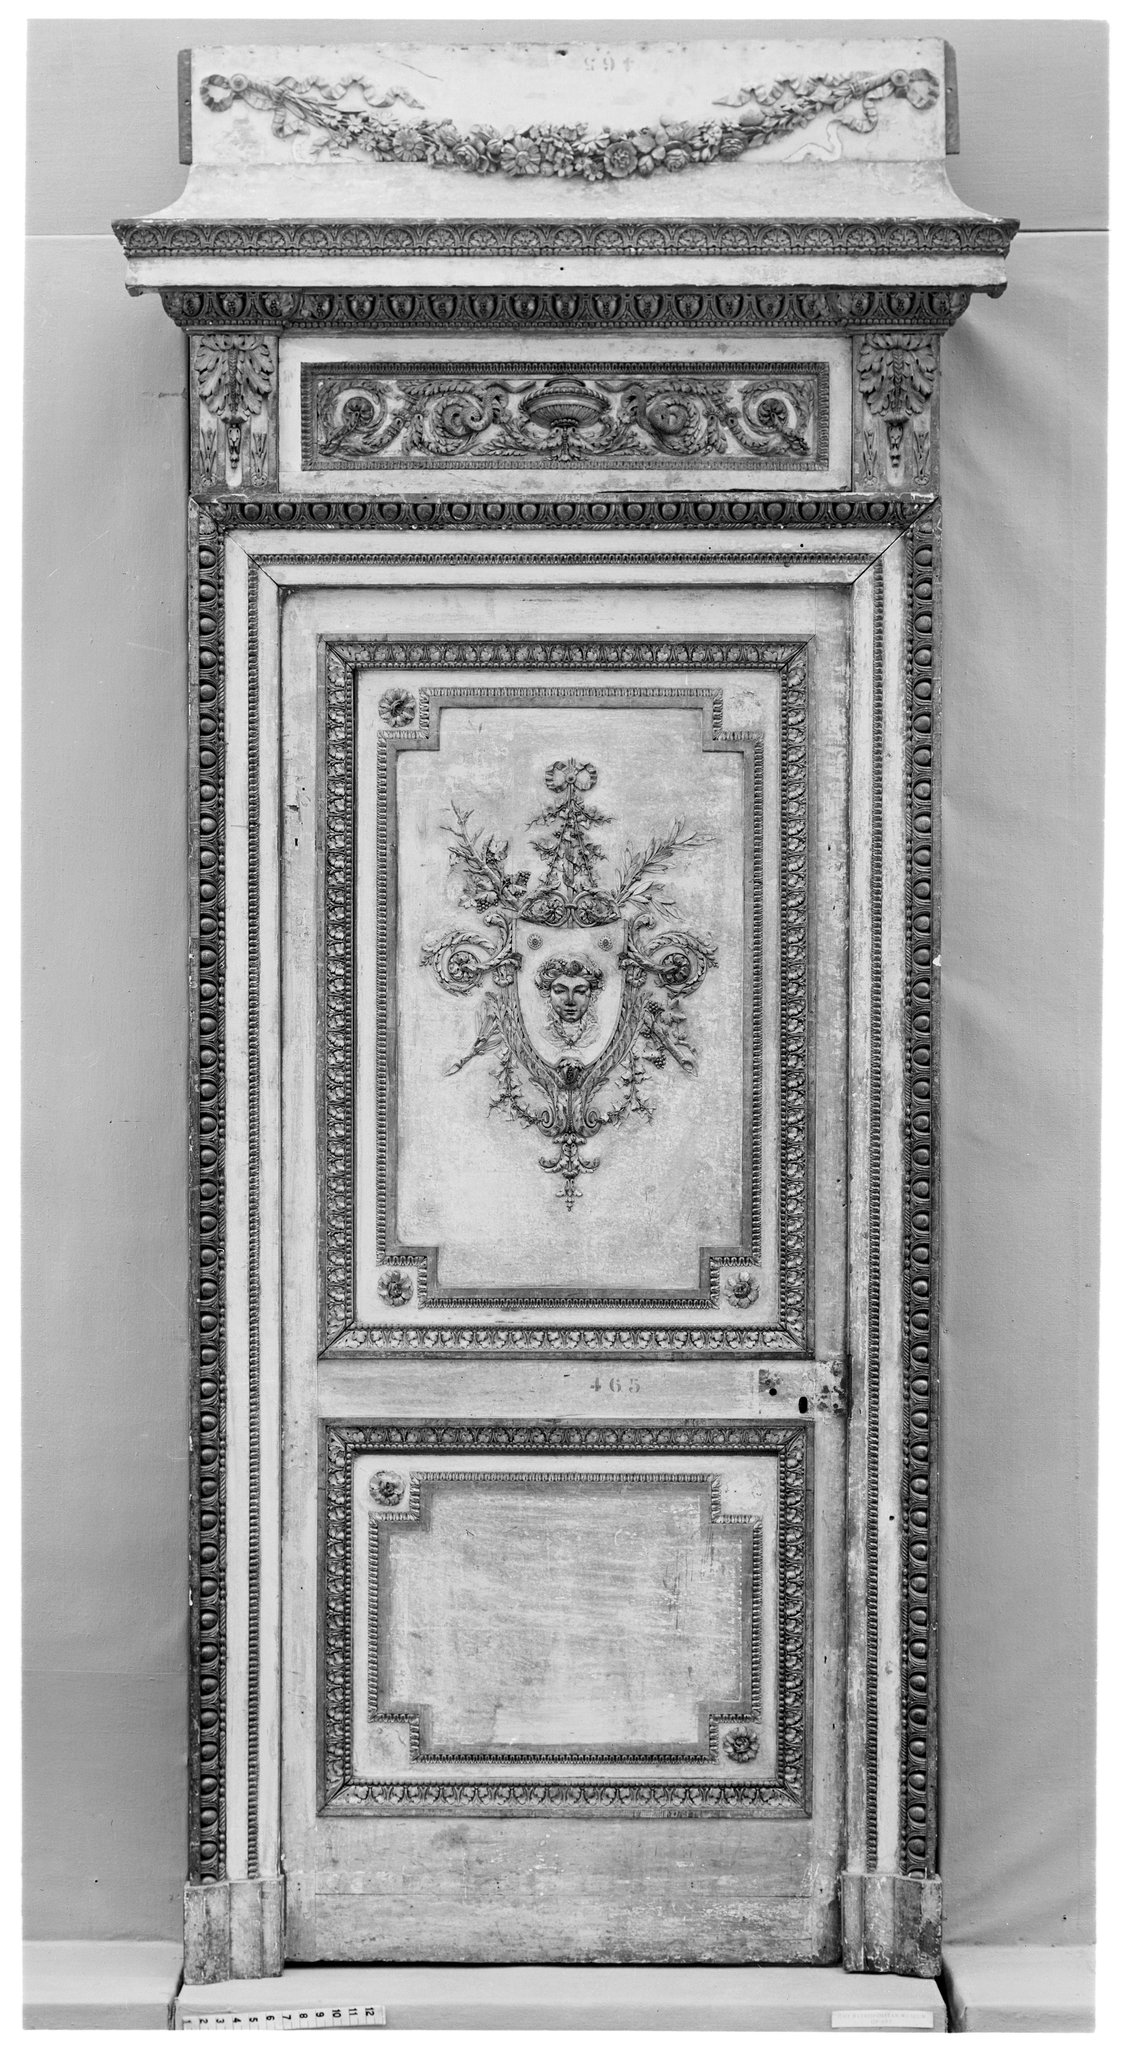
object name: door and doorway with overdoor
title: Door from the cabinet intérieur of Étienne-François, duc de Choiseul (1719-1785), at his château of Chanteloup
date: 1771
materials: wood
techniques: carving, gilding, painting